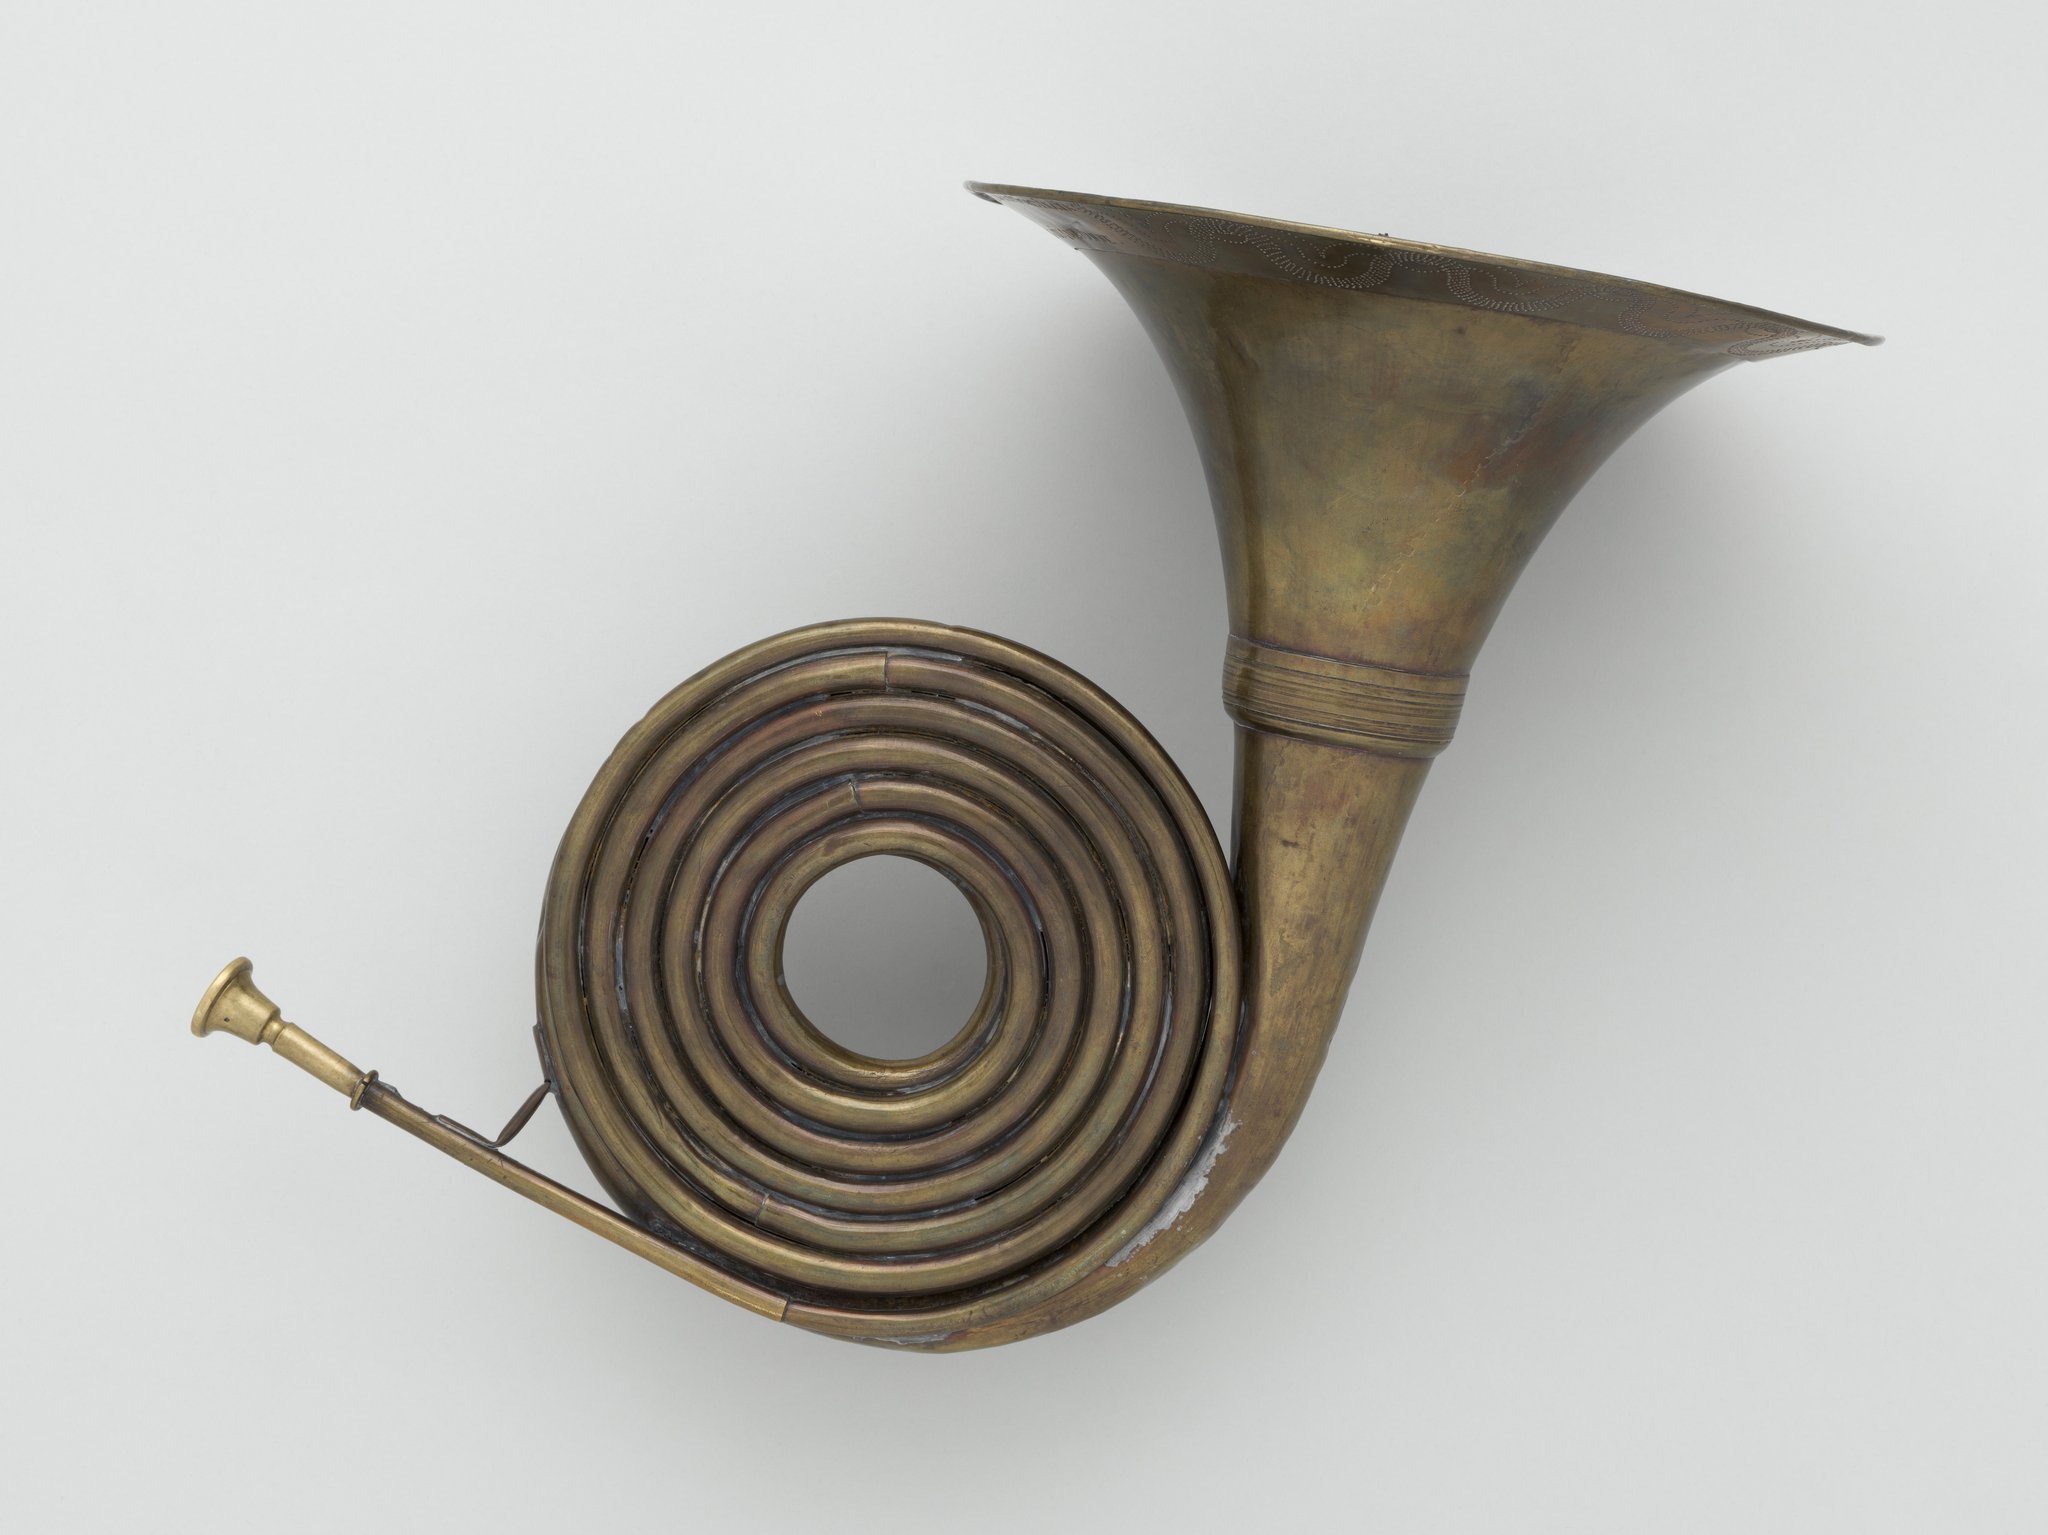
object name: trompe de chasse in c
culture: french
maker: joseph raoux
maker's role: maker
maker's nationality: french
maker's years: 1725-1800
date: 1759-1769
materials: brass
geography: france